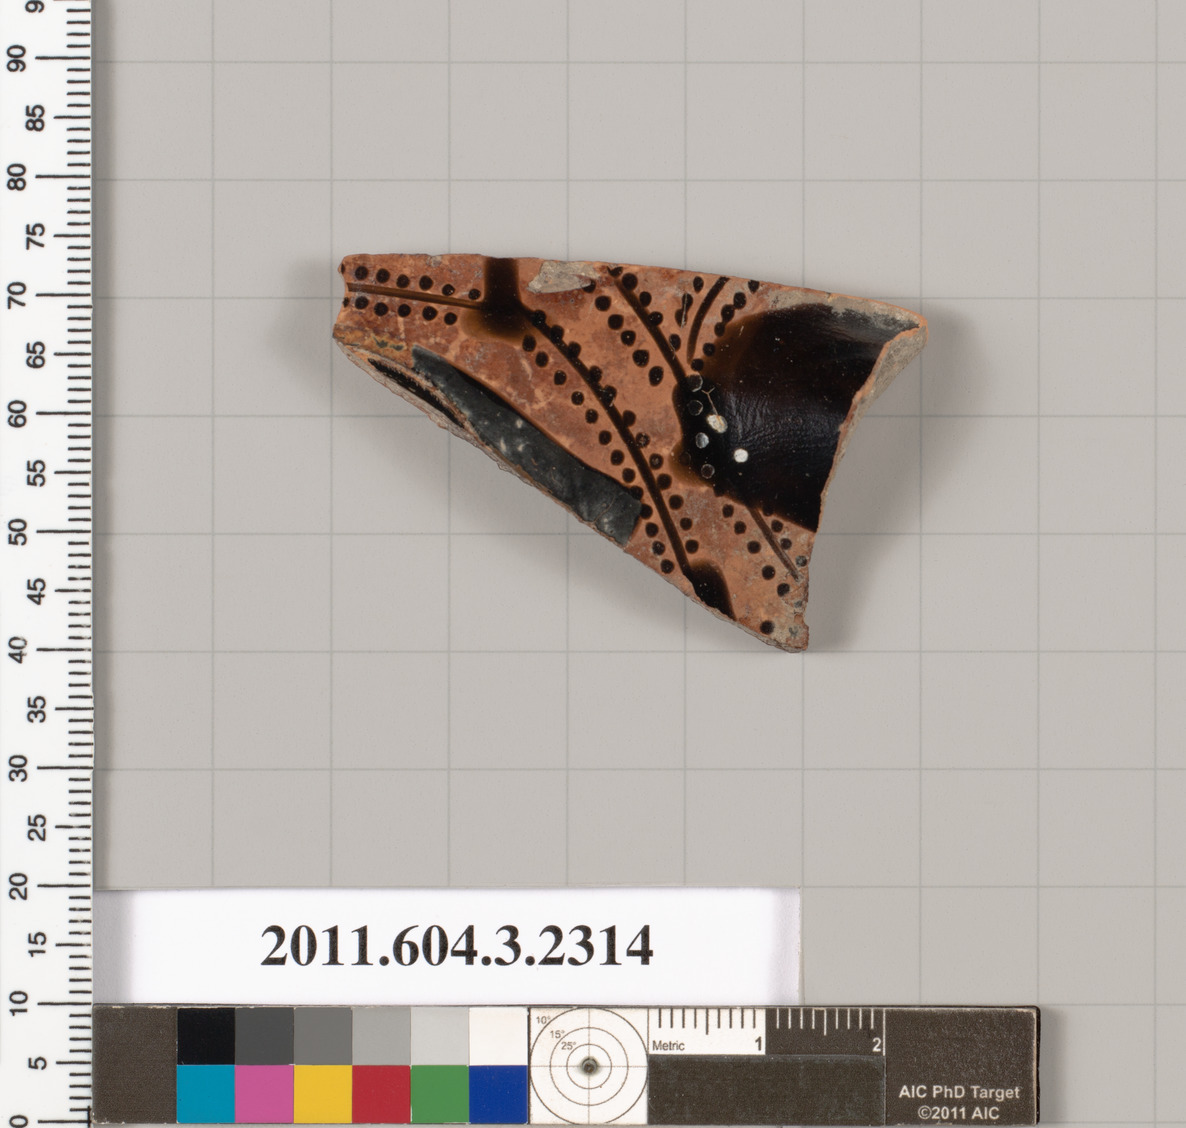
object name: kylix fragment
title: Terracotta fragment of a kylix: eye-cup (drinking cup)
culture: greek, attic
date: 520-510 BCE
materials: terracotta